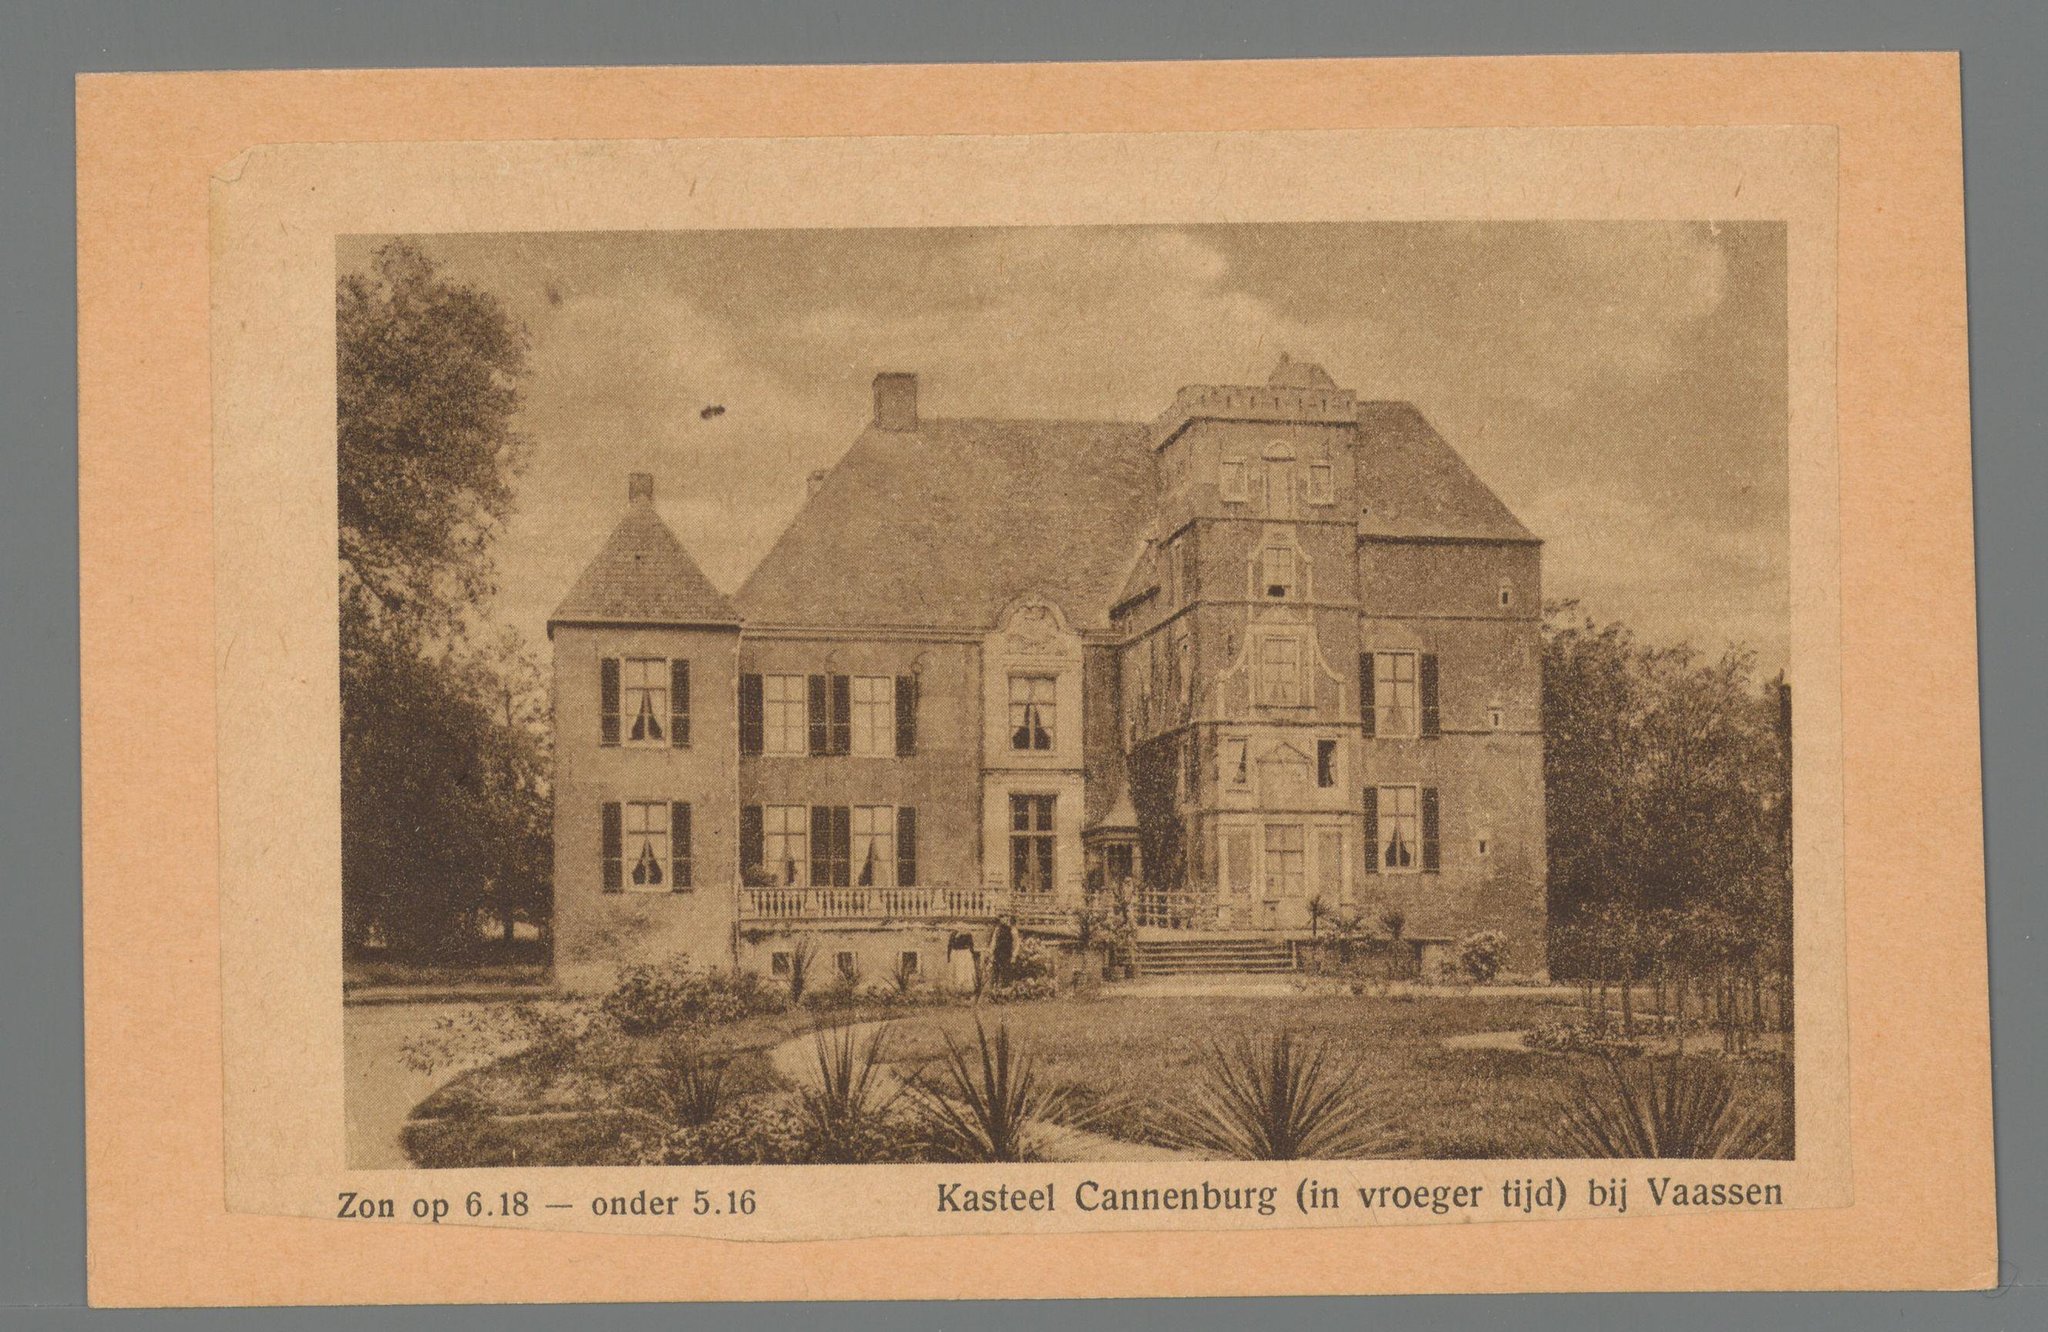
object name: ansichtkaart, prentbriefkaart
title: Kasteel Cannenburg (in vroeger tijd) bij Vaassen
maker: Anonymous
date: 1895-1930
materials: cardboard, paper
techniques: rotogravure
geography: vaassen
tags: castle